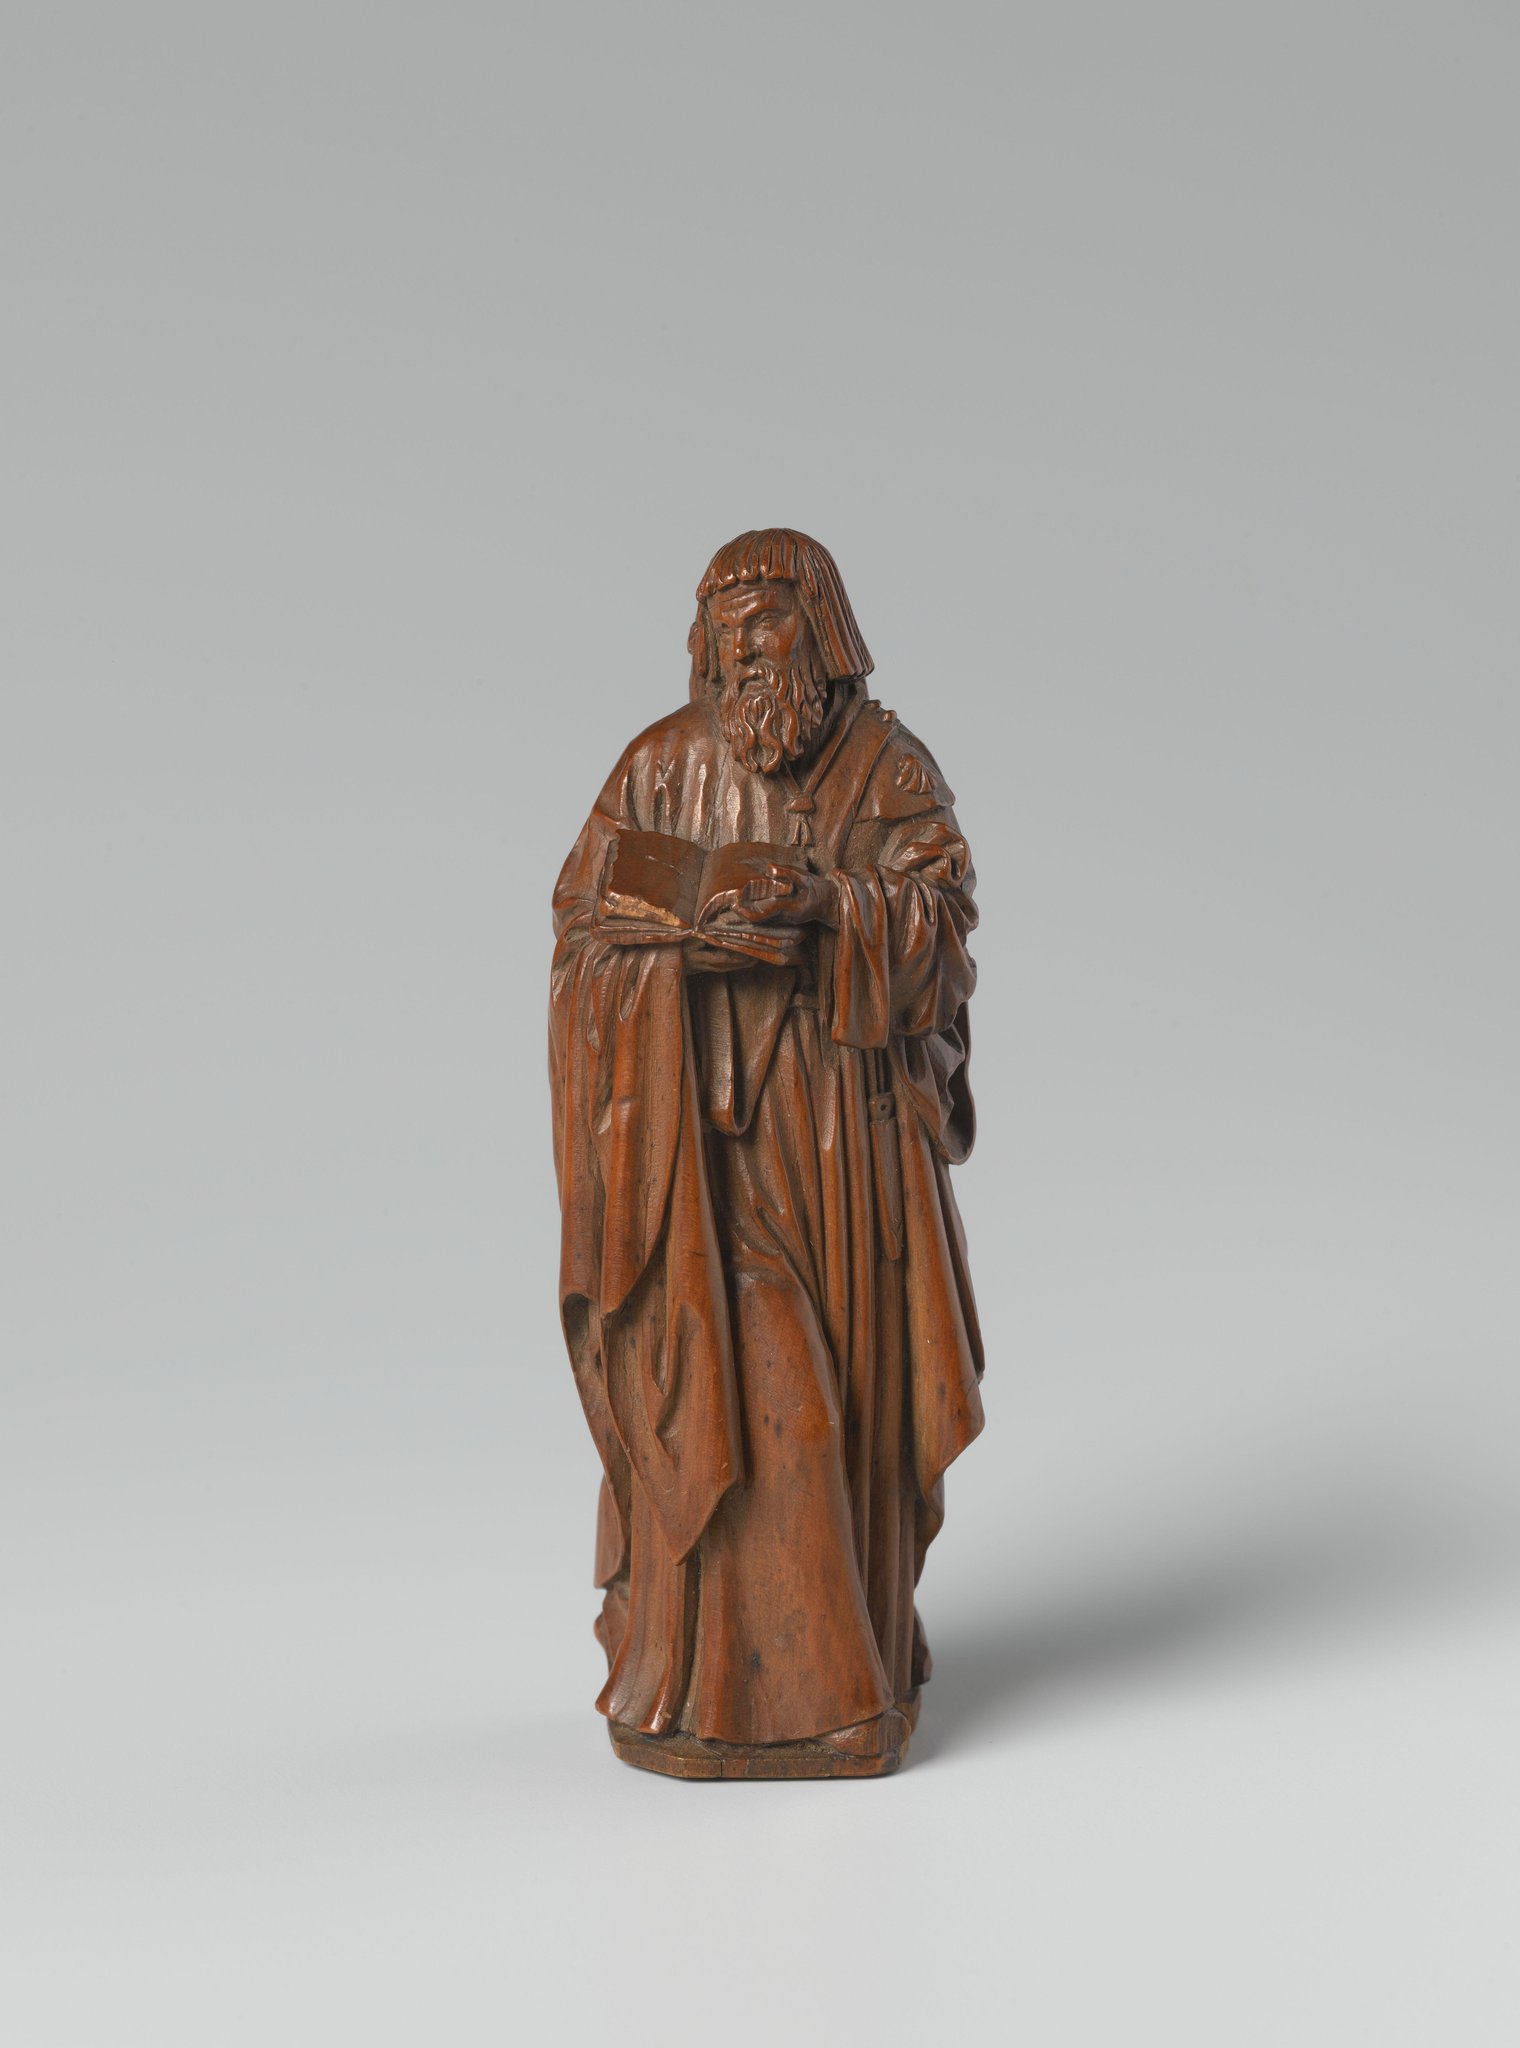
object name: figure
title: St James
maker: master of st anthony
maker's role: sculptor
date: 1490-1500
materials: wood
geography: lower rhine region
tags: the apostle james the great; possible attributes: book, pilgrim's cloak, hat, shell, staff, and wallet, scroll, sword - specific aspects ~ male saint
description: Meester van Sint-Antonius (werkzaam ca. 1475-1500)?, Nederrijn (Hertogdom Kleef?), ca. 1480-1510, buxushout